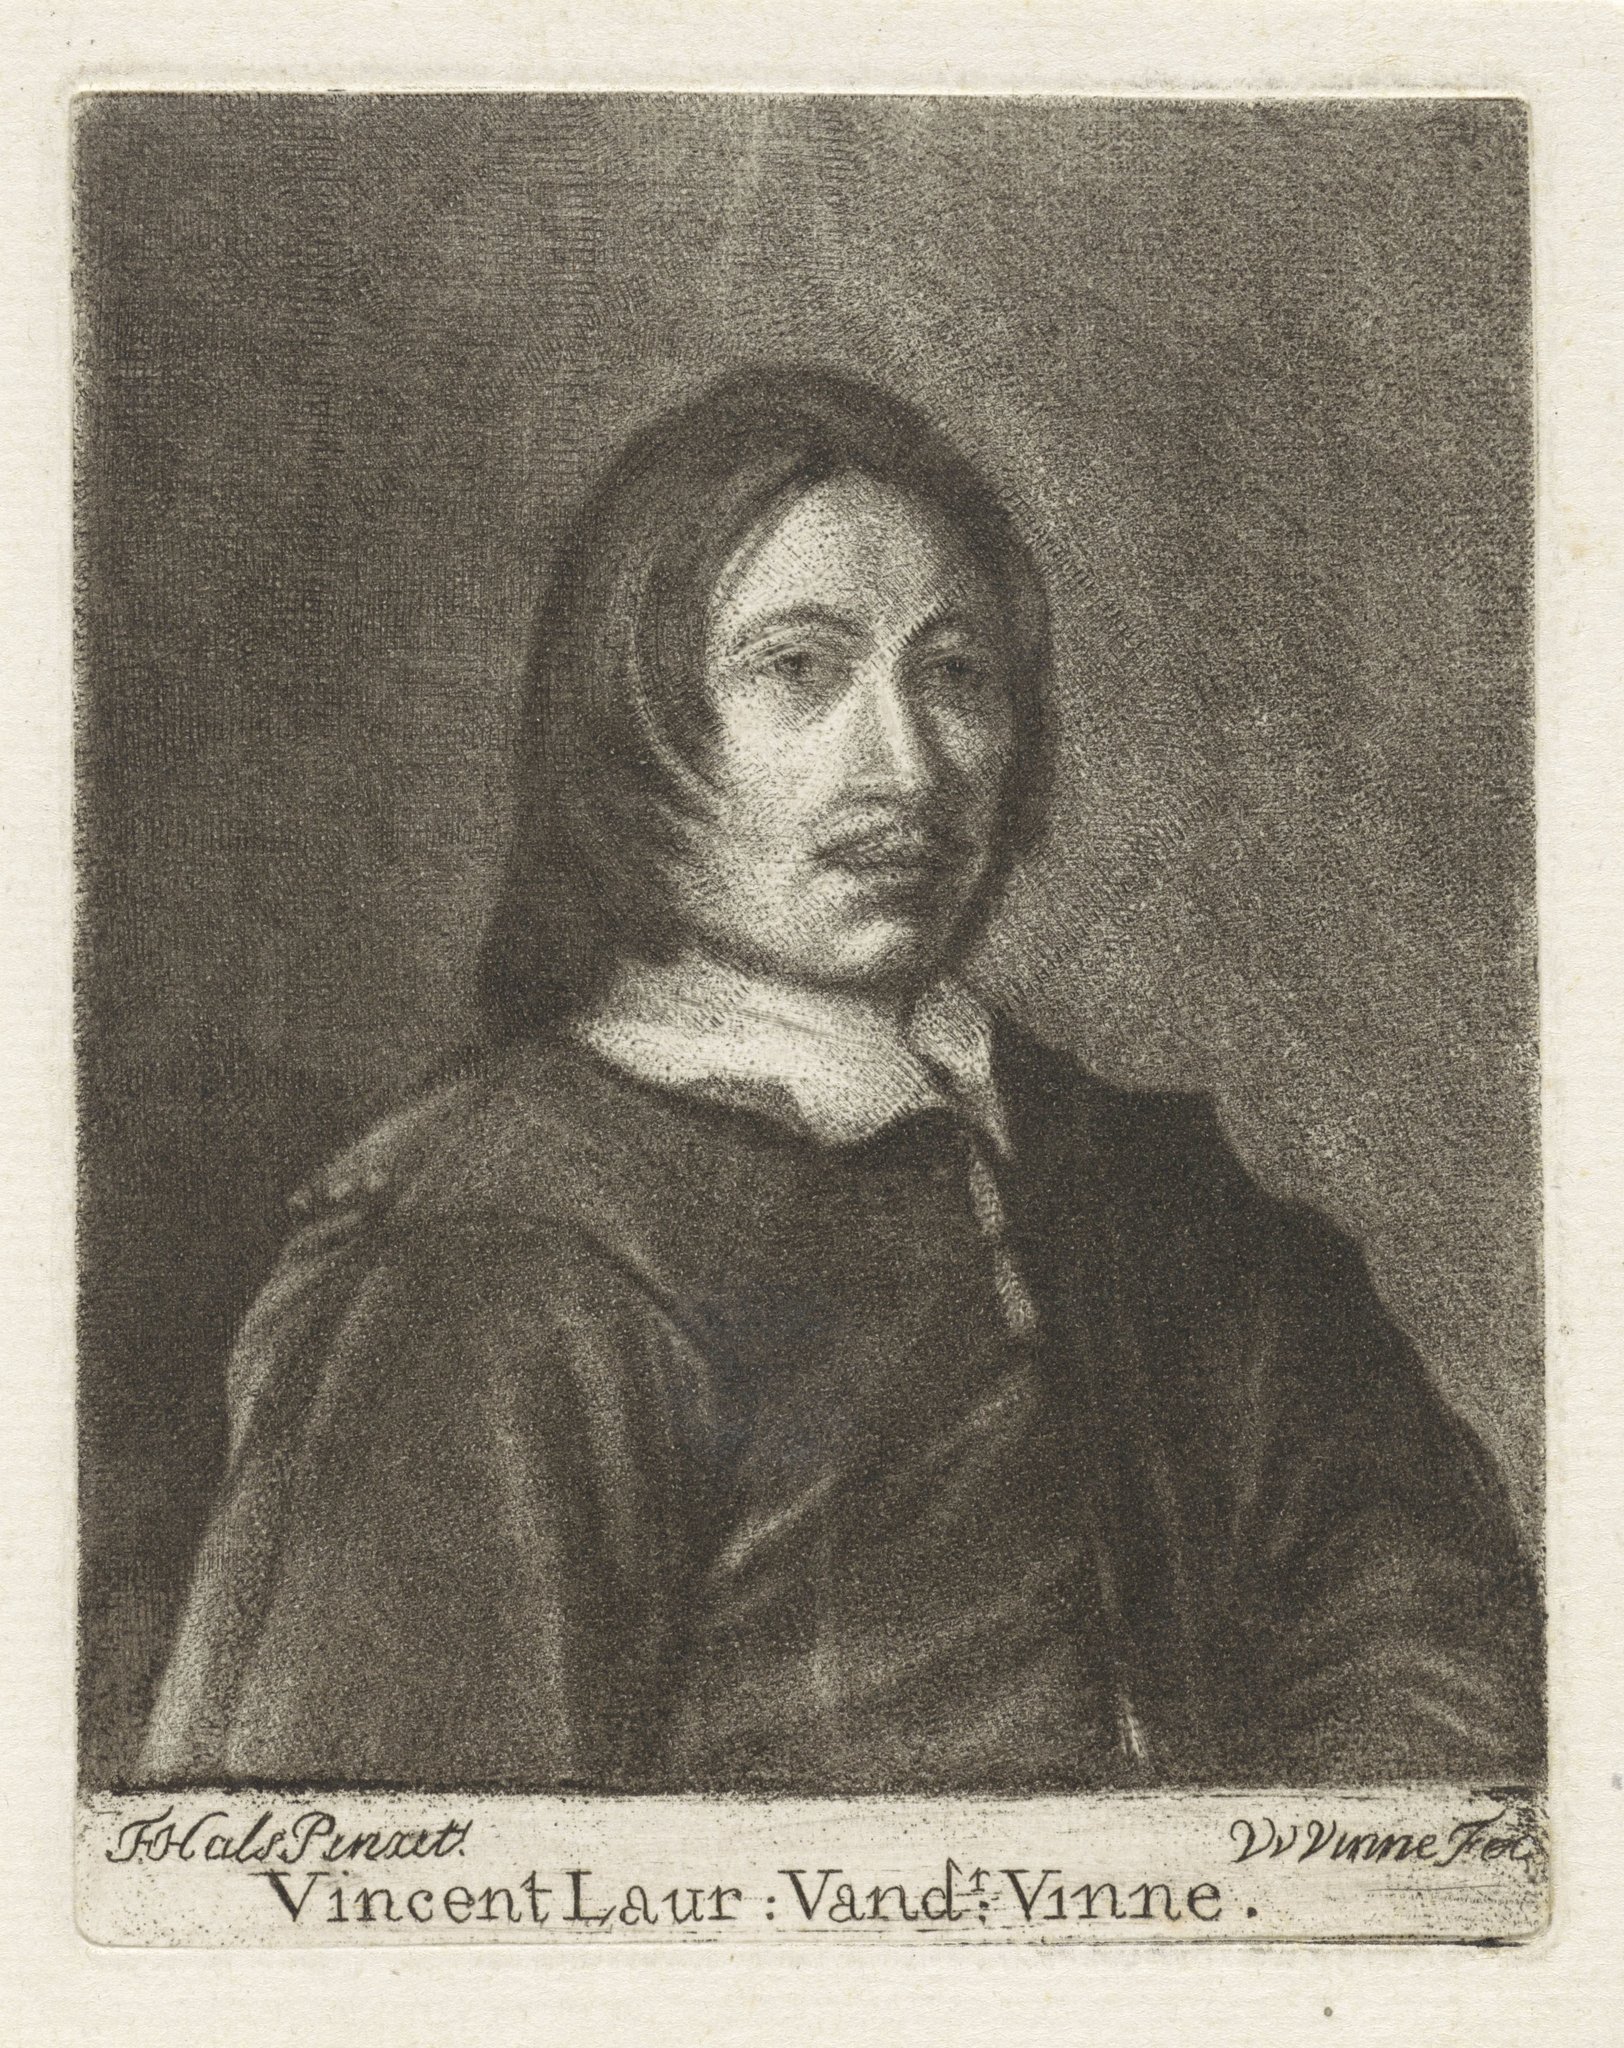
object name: print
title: Portret van Vincent Laurensz. van der Vinne I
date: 1696-1742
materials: paper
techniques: mezzotint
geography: haarlem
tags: haarlem, print maker, vincent laurensz. van der vinne (i), portrait, self-portrait of artist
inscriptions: collector's mark: Lugt 2228